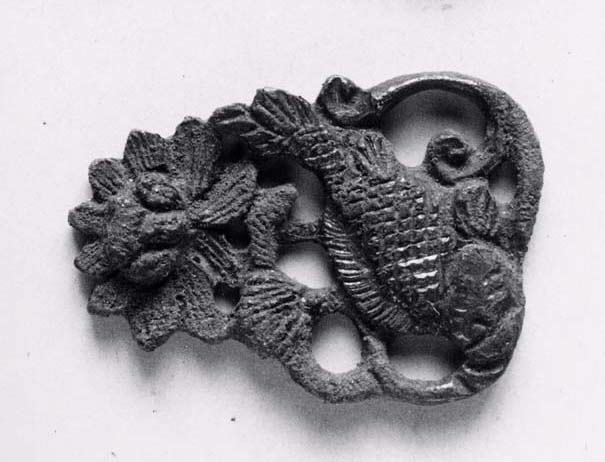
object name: ornament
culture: korean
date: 918-1392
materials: silver